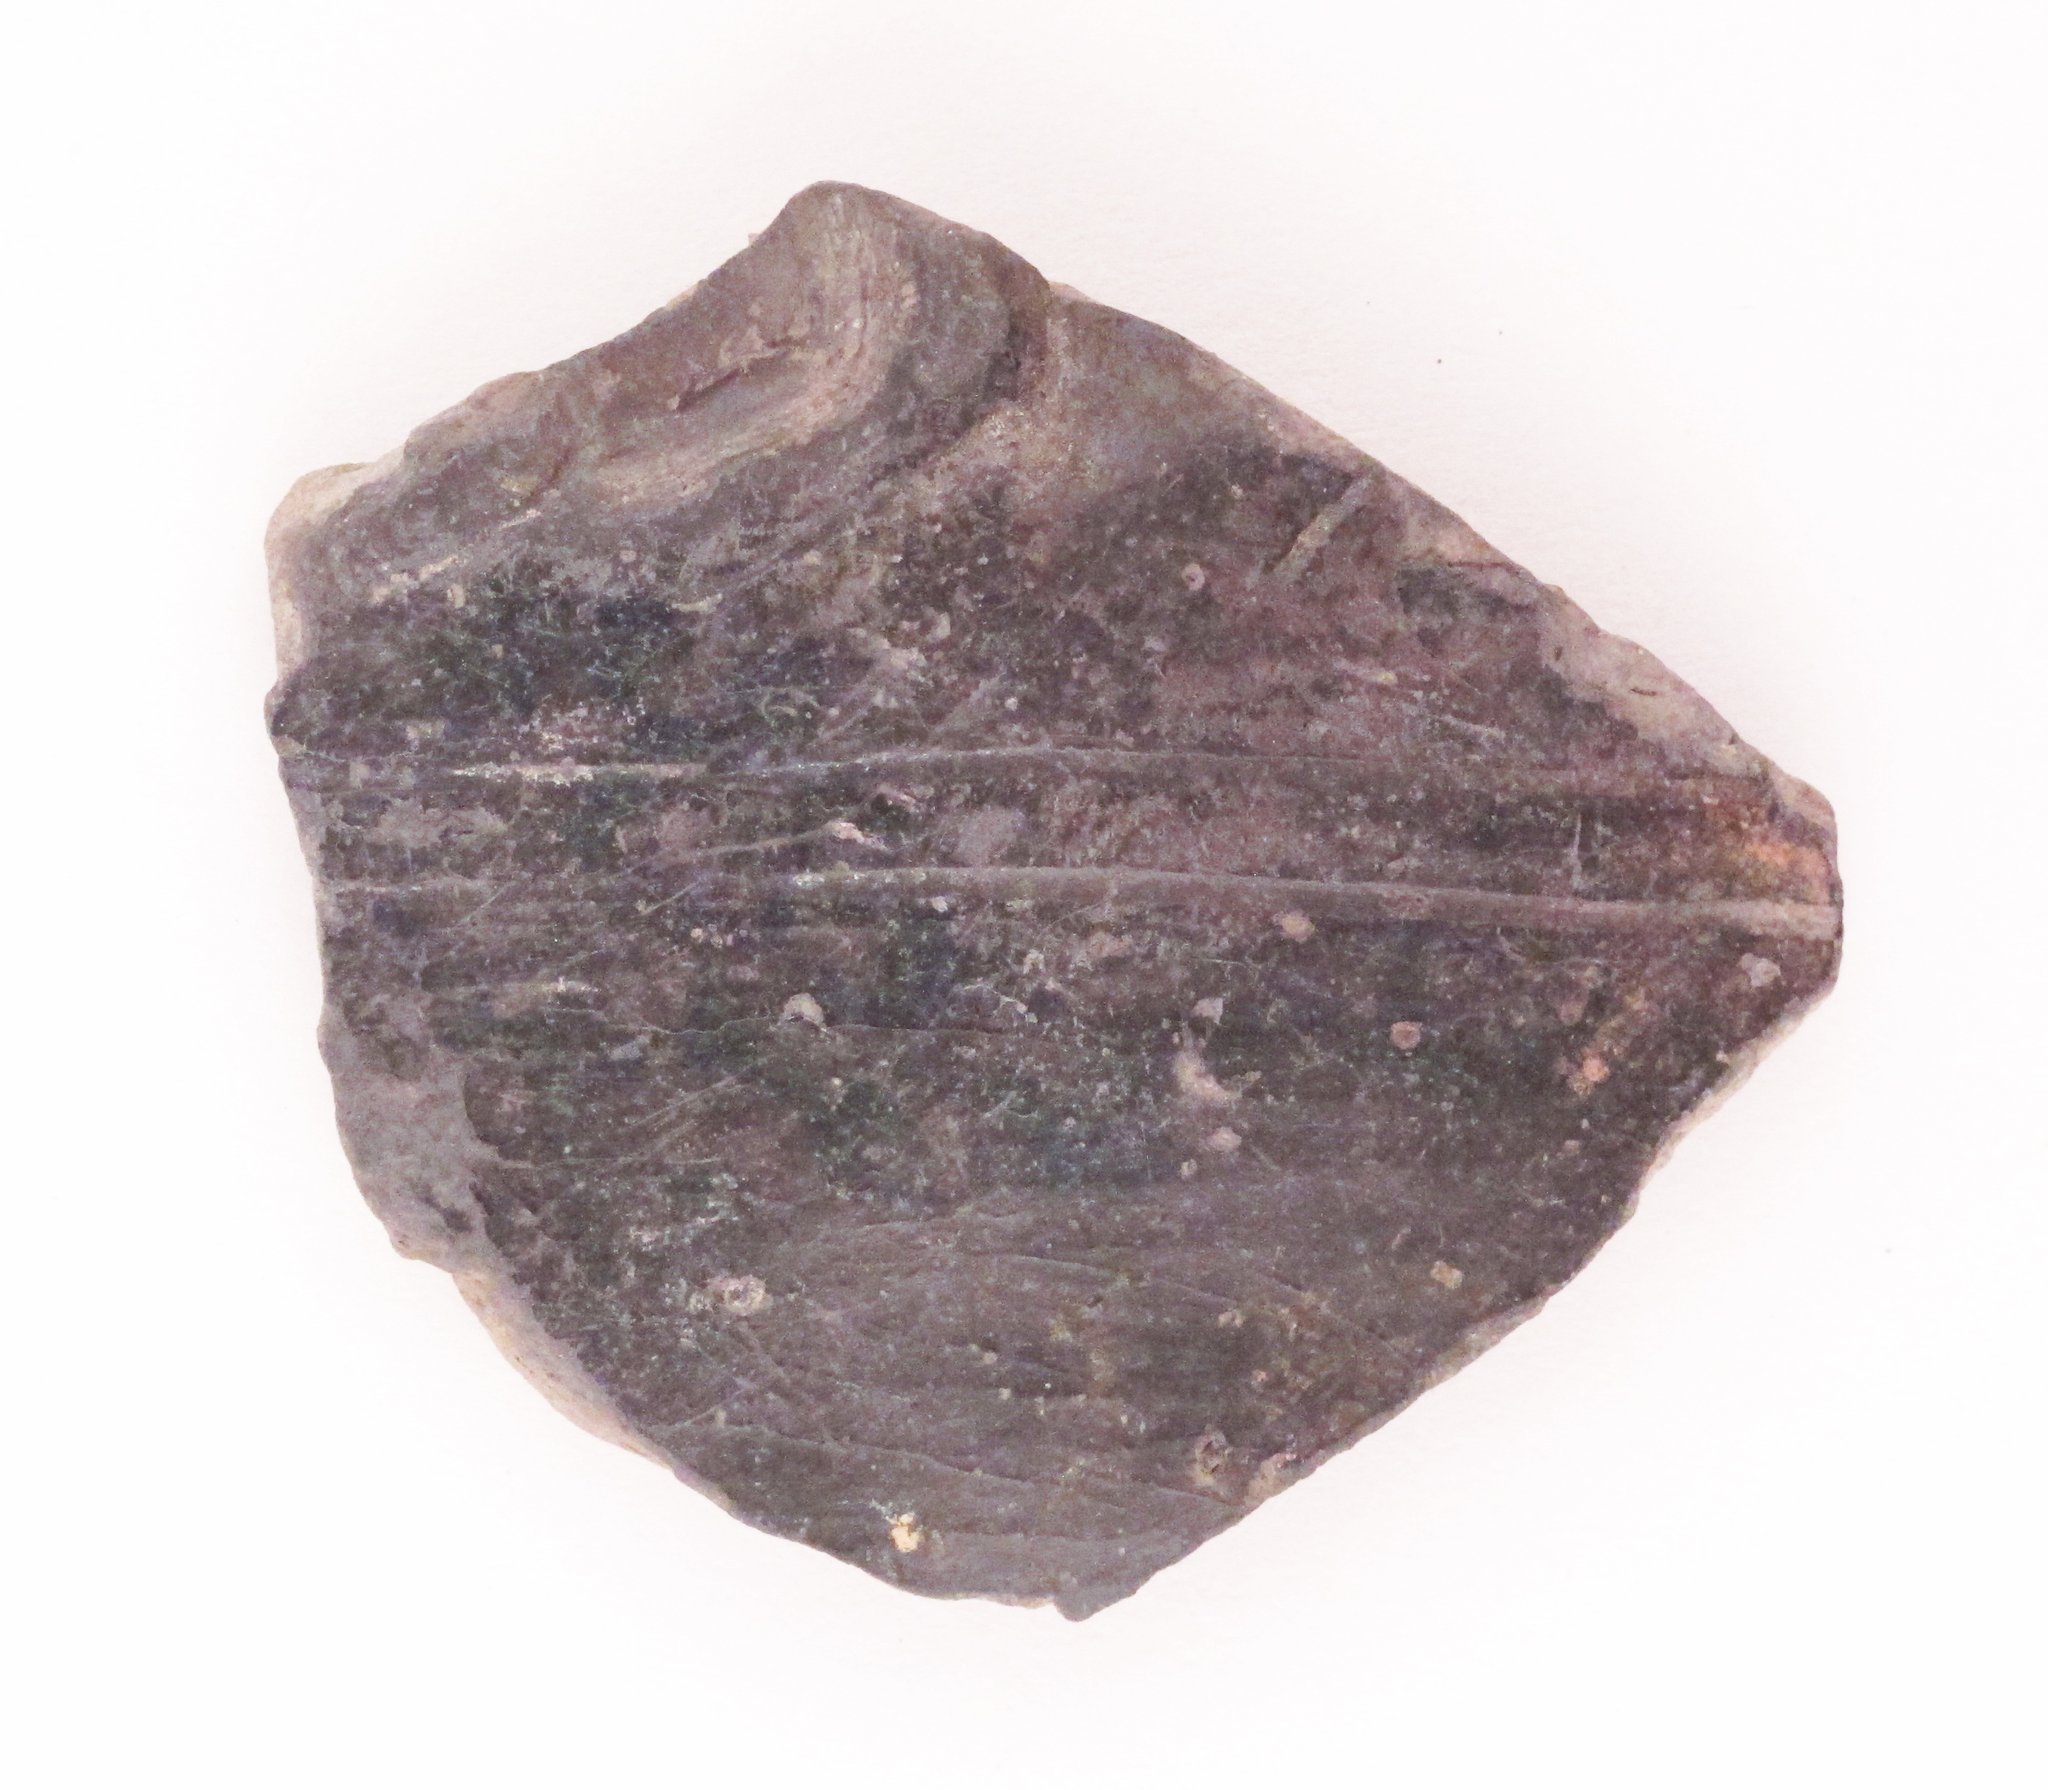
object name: vase fragment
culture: etruscan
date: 575-550 BCE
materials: terracotta